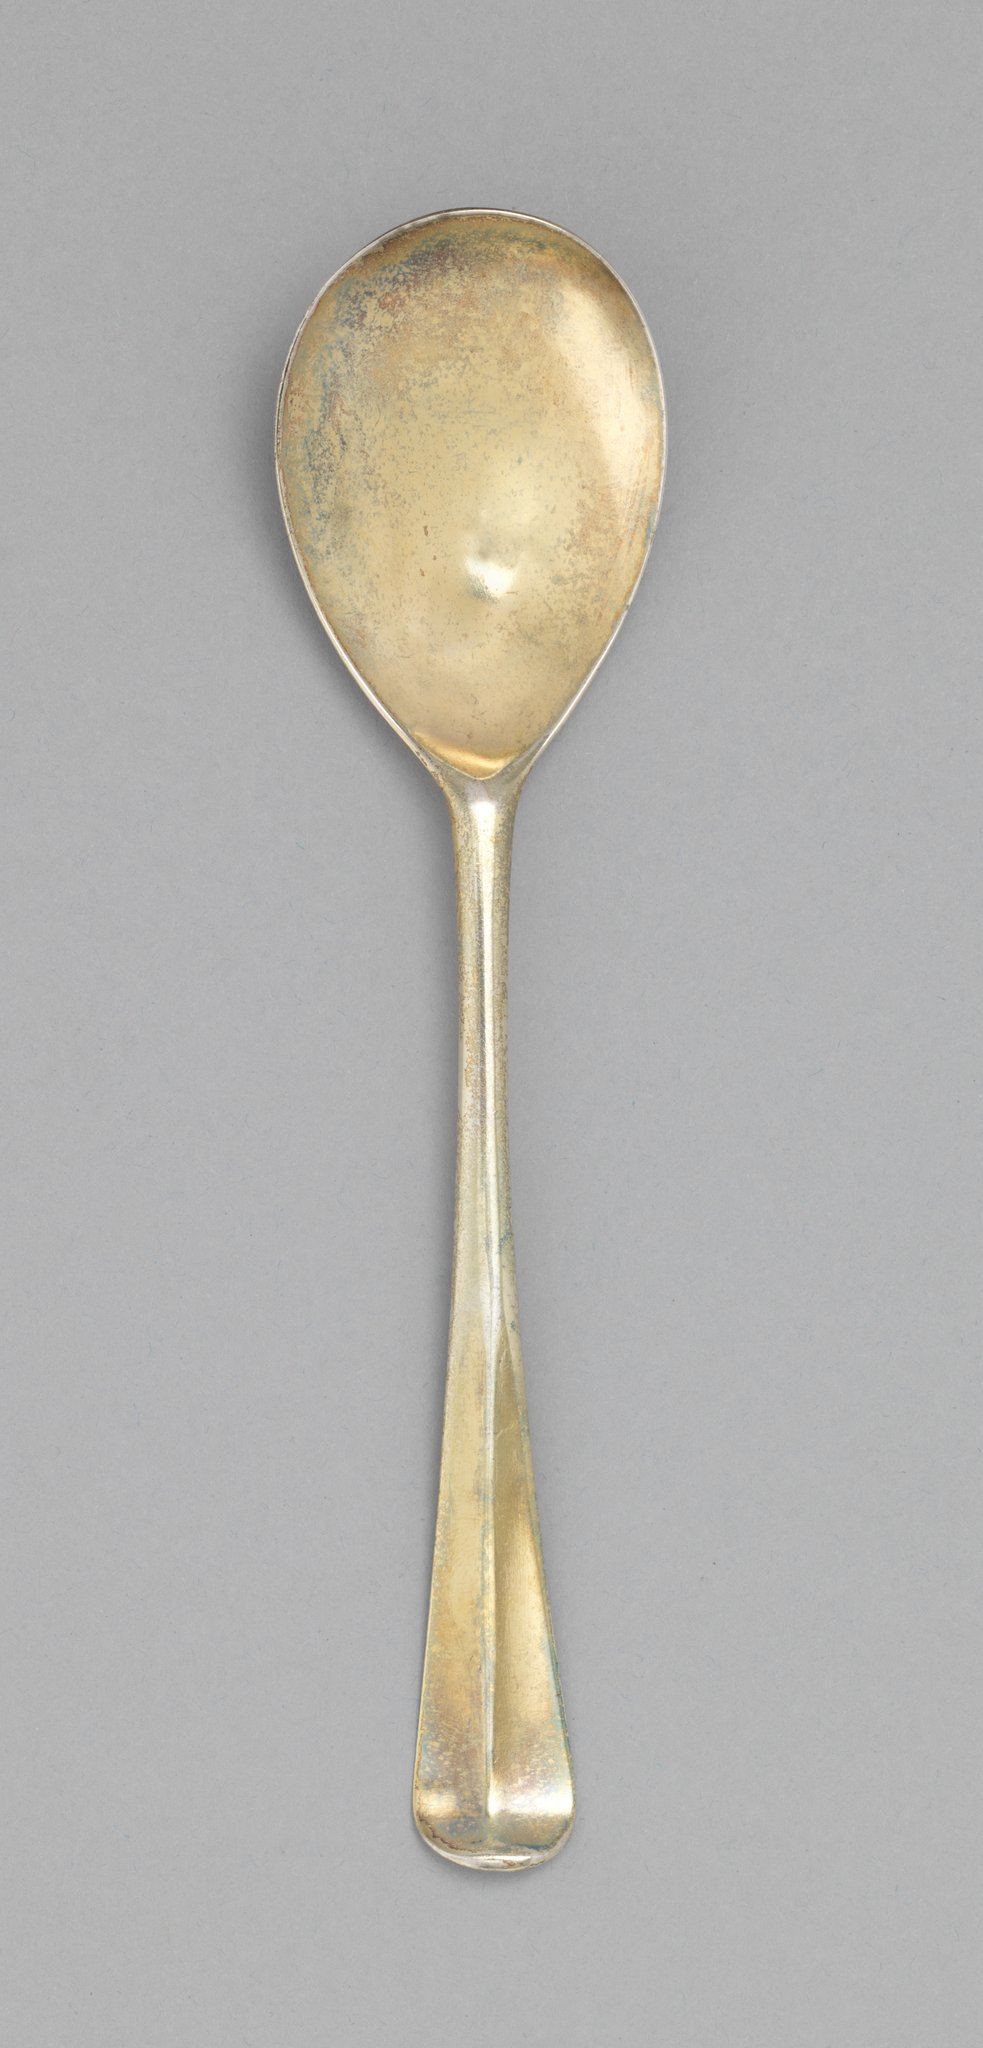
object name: dessert spoon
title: Three dessert spoons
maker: john pittar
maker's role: maker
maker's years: 1778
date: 1734-1766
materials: silver gilt